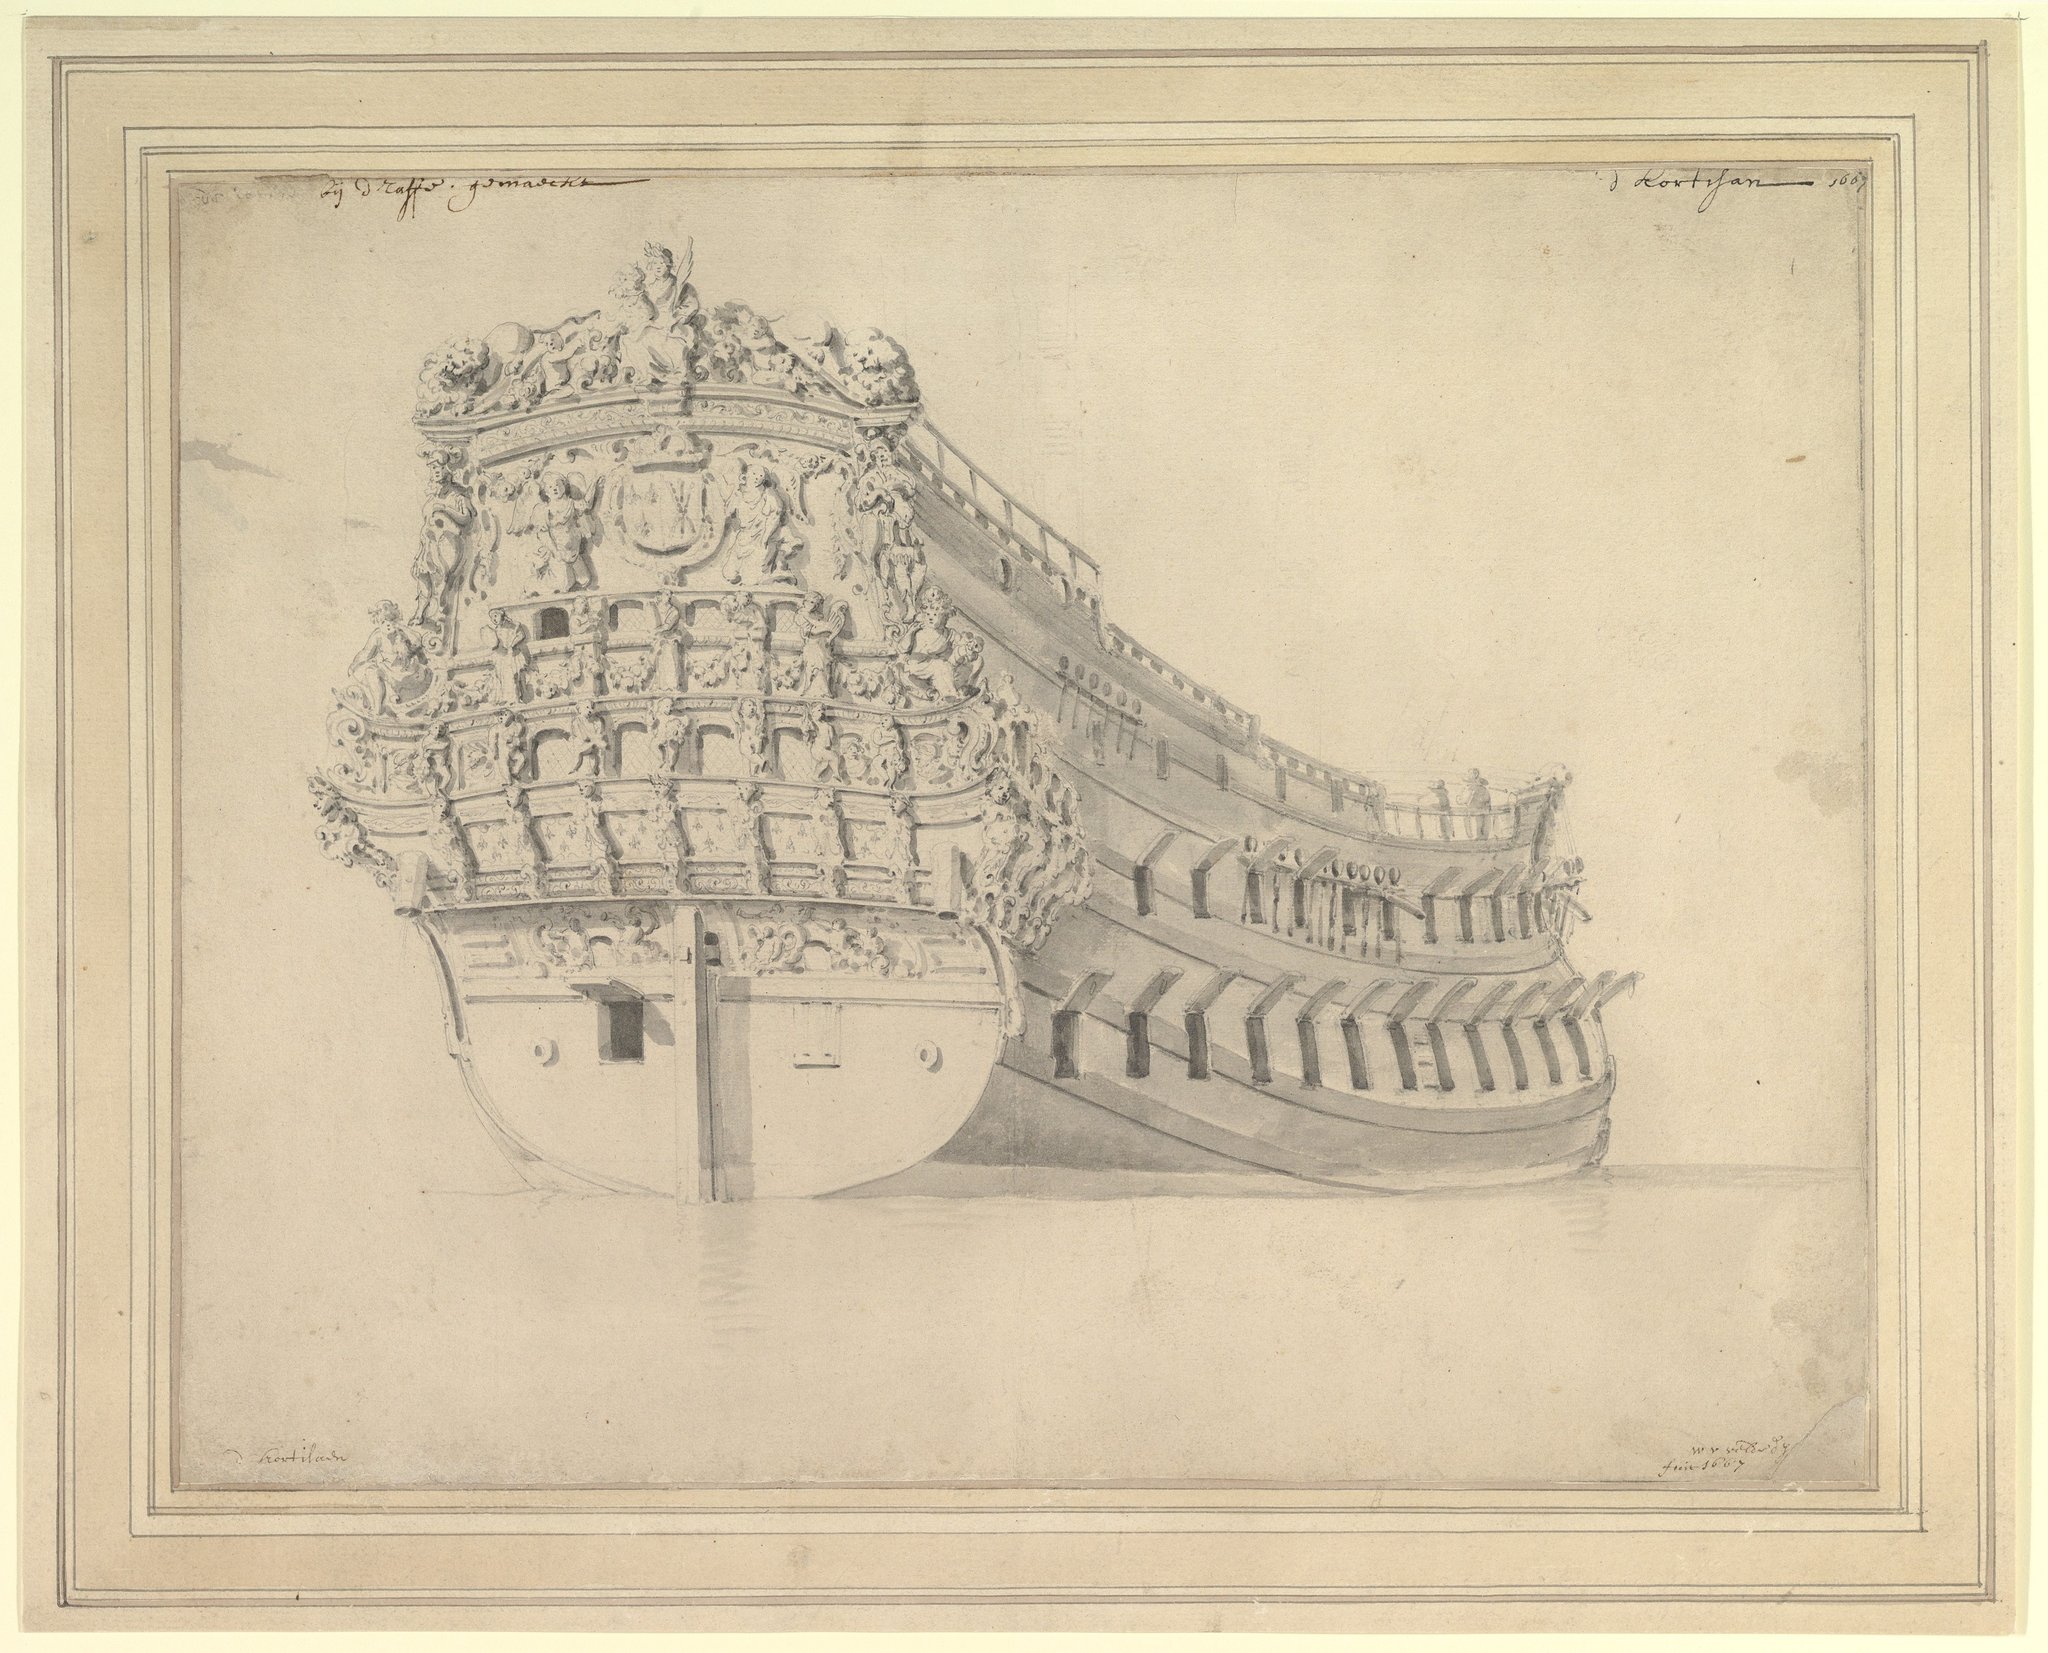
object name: drawing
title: The French Vessel "Courtisan"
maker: willem van de velde (ii)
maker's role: artist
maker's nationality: dutch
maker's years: 1633-1707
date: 1634-1733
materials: chalk, ink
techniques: brush, pen, wash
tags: ships